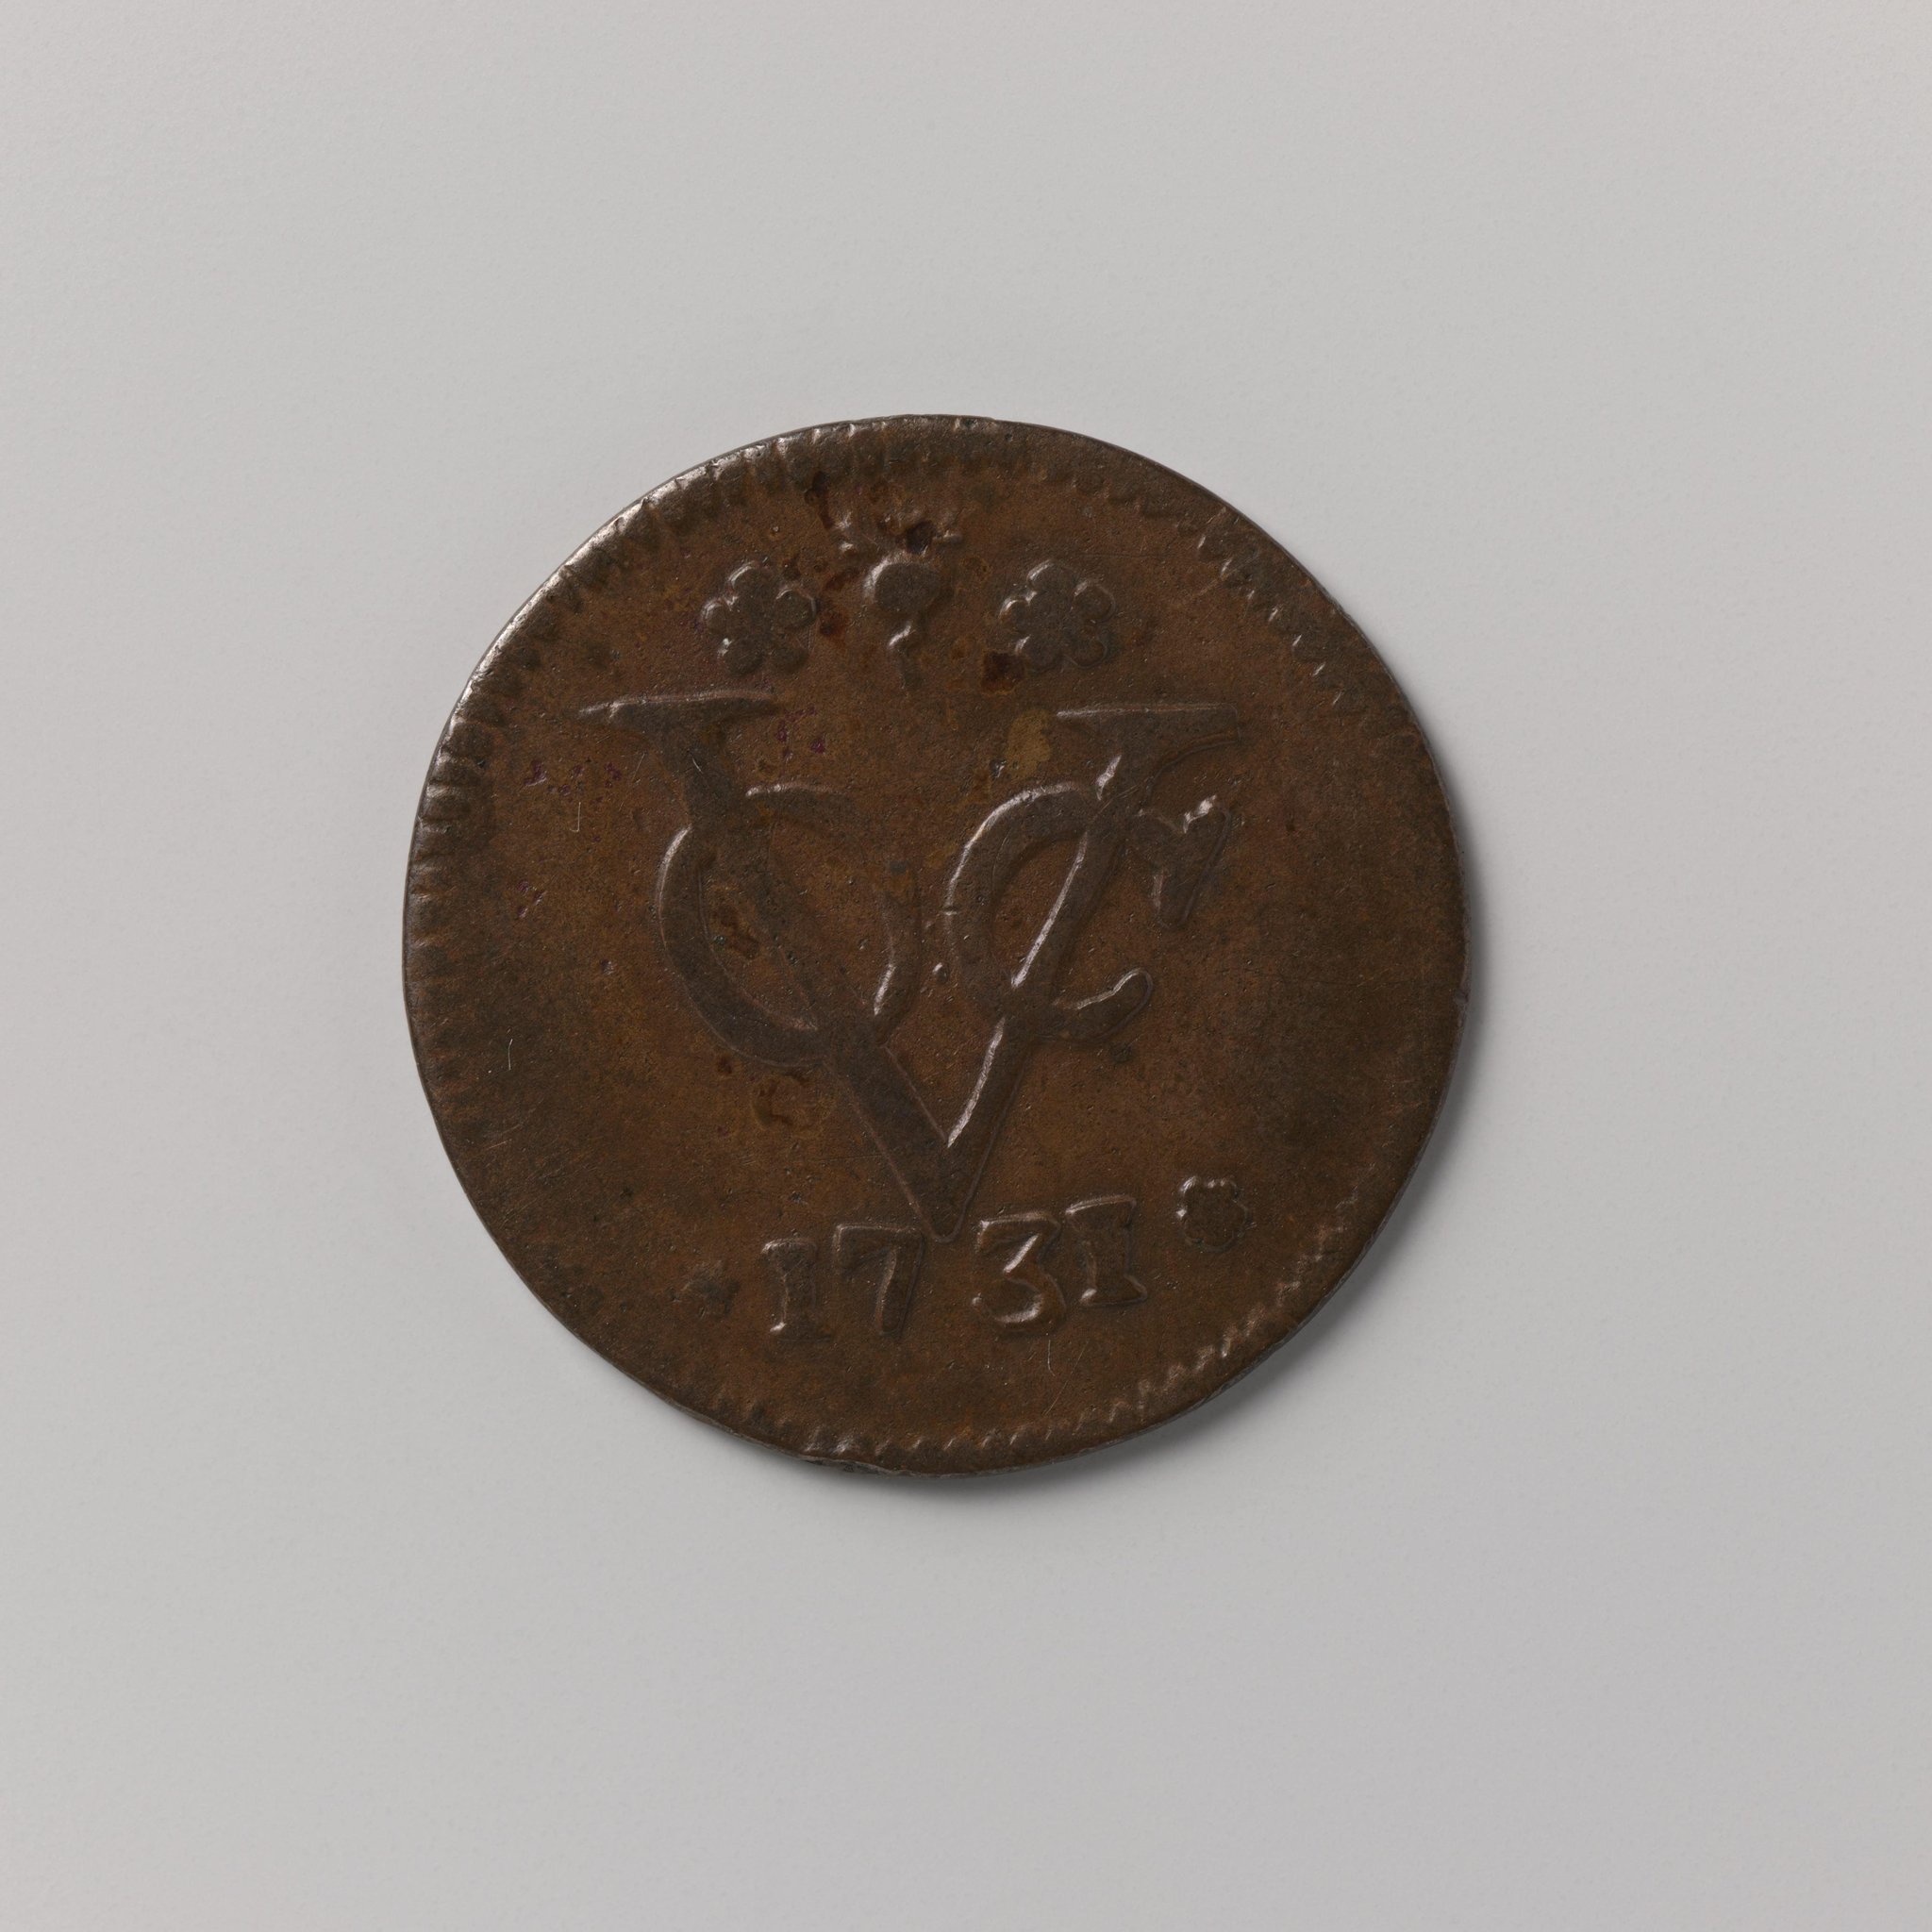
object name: coin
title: VOC, duit Westfriesland, 1731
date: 1731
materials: copper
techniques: striking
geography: hoorn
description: Koperen munt. Voorzijde: ingebogen gekroond wapenschild van Westfriesland. Keerzijde: monogram van de VOC, waarboven muntmeesterteken en waaronder jaartal. Gladde rand.